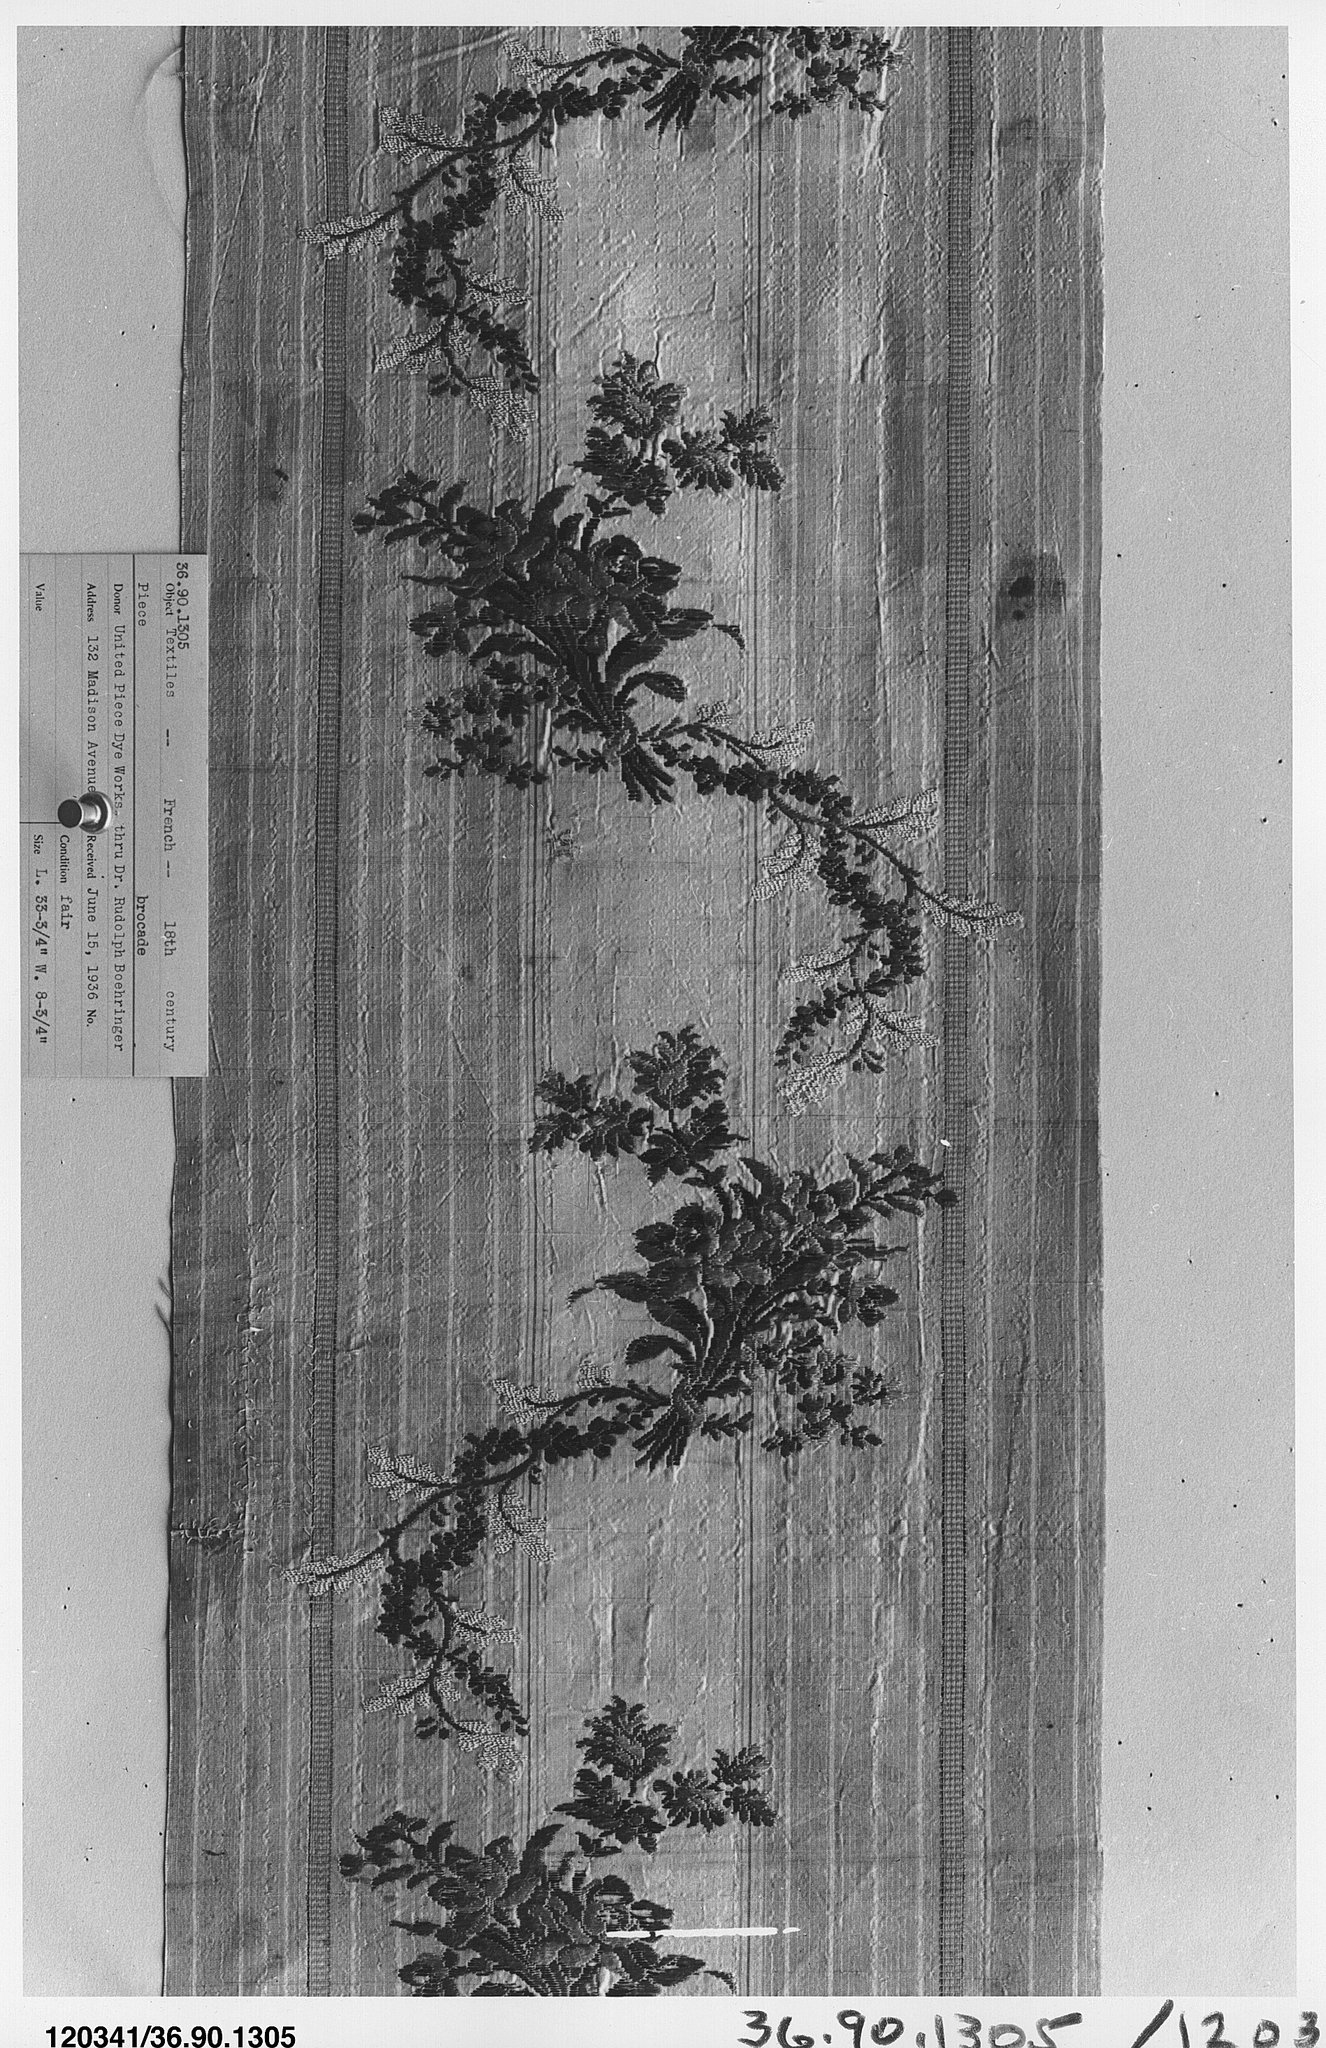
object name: piece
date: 1701-1800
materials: silk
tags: flowers,leaves